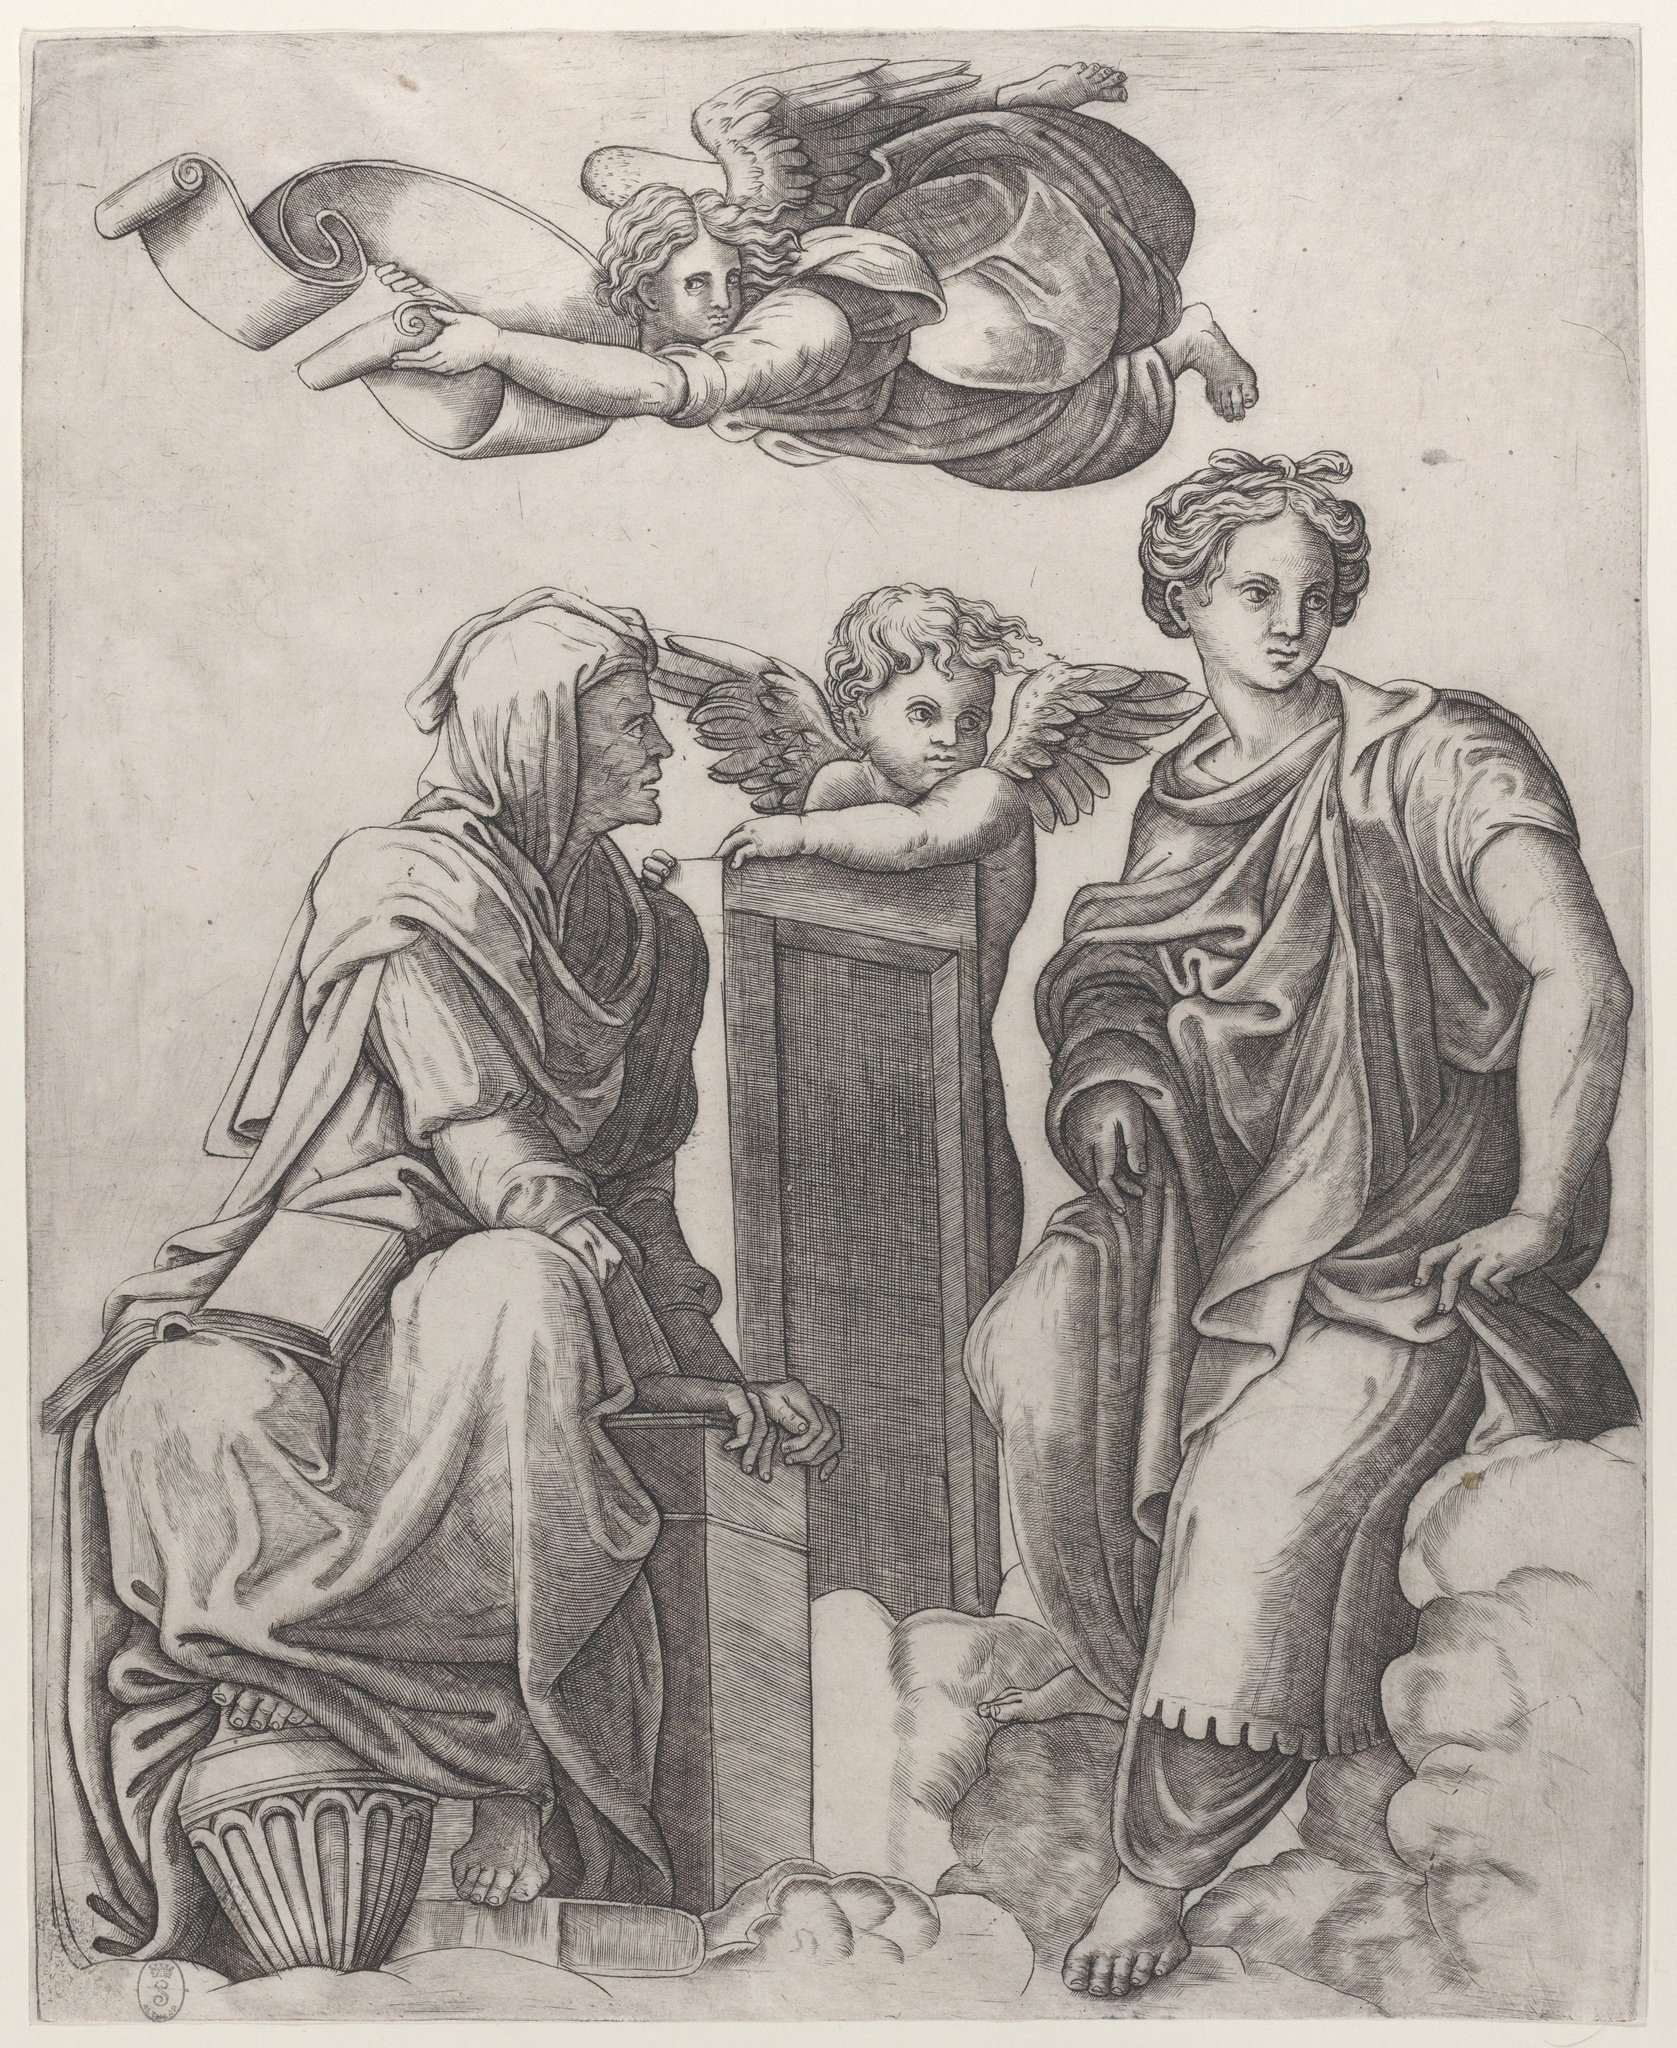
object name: print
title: Two female figures seated in the clouds flanking an angel and another flying above carrying a banderole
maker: giovanni antonio da brescia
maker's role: artist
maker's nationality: italian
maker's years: 1490-1525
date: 1510-1525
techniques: engraving